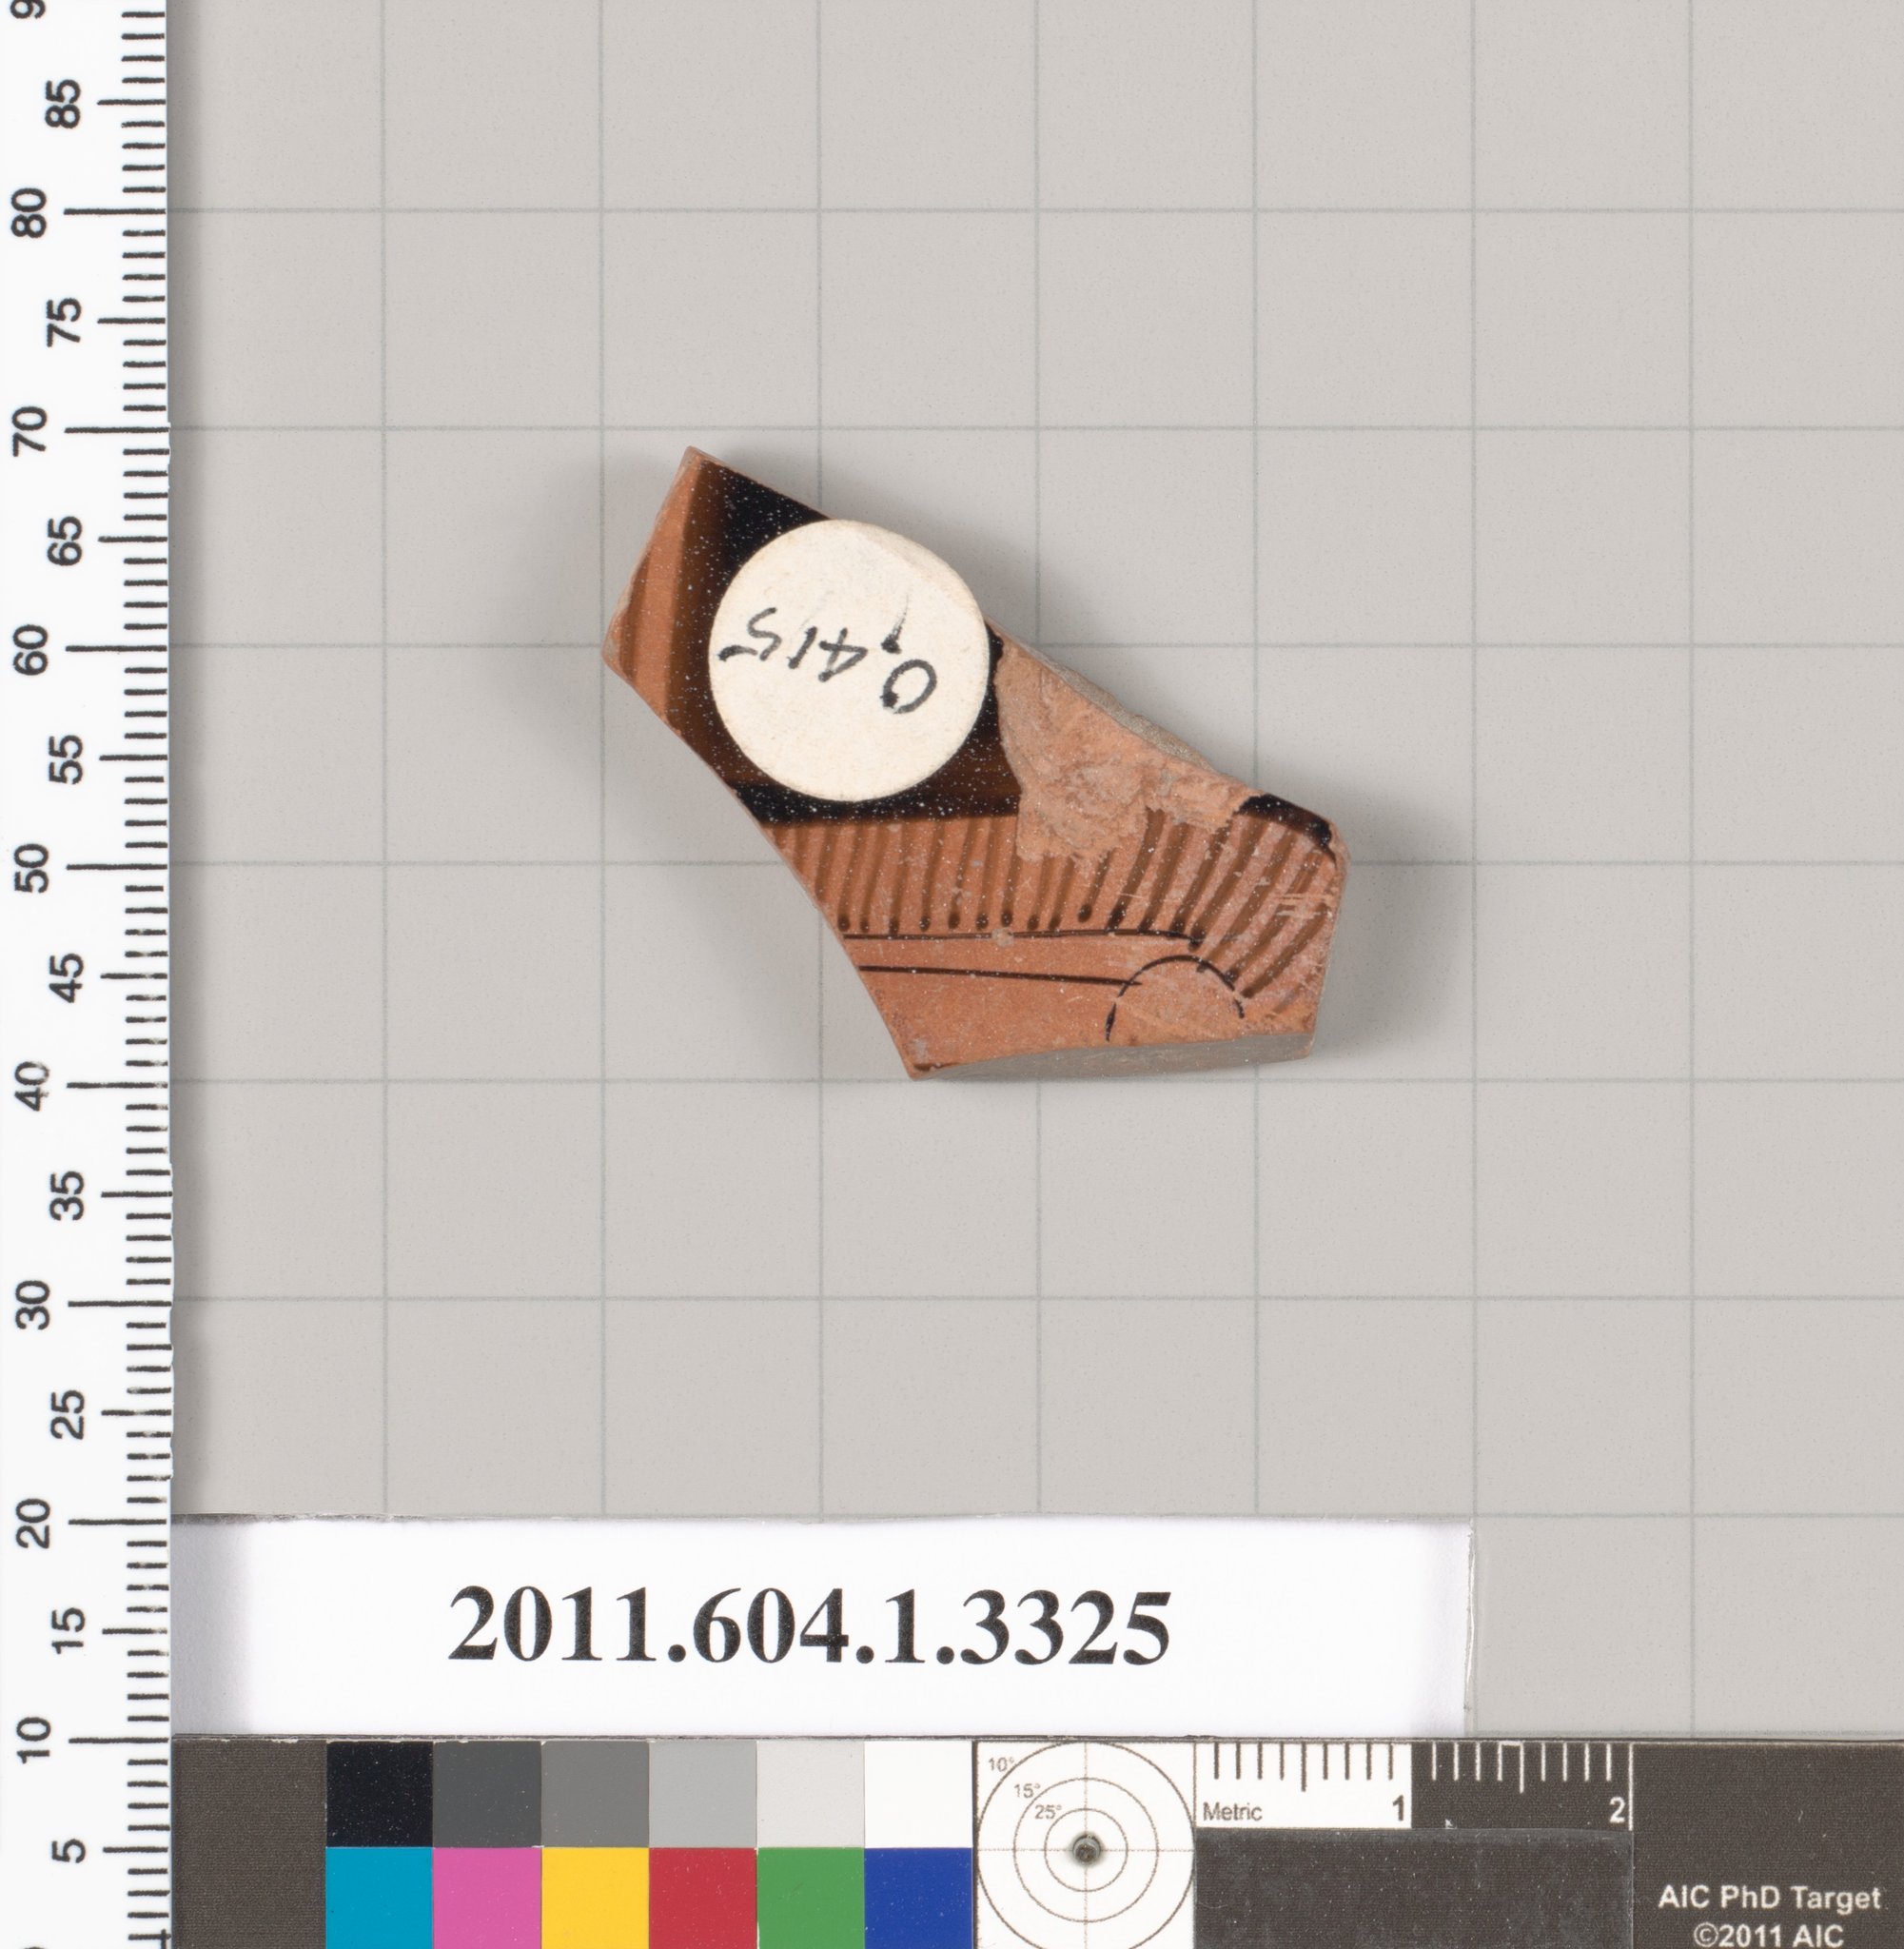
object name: kylix fragment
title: Terracotta fragment of a kylix (drinking cup)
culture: greek, attic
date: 500-476 BCE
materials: terracotta